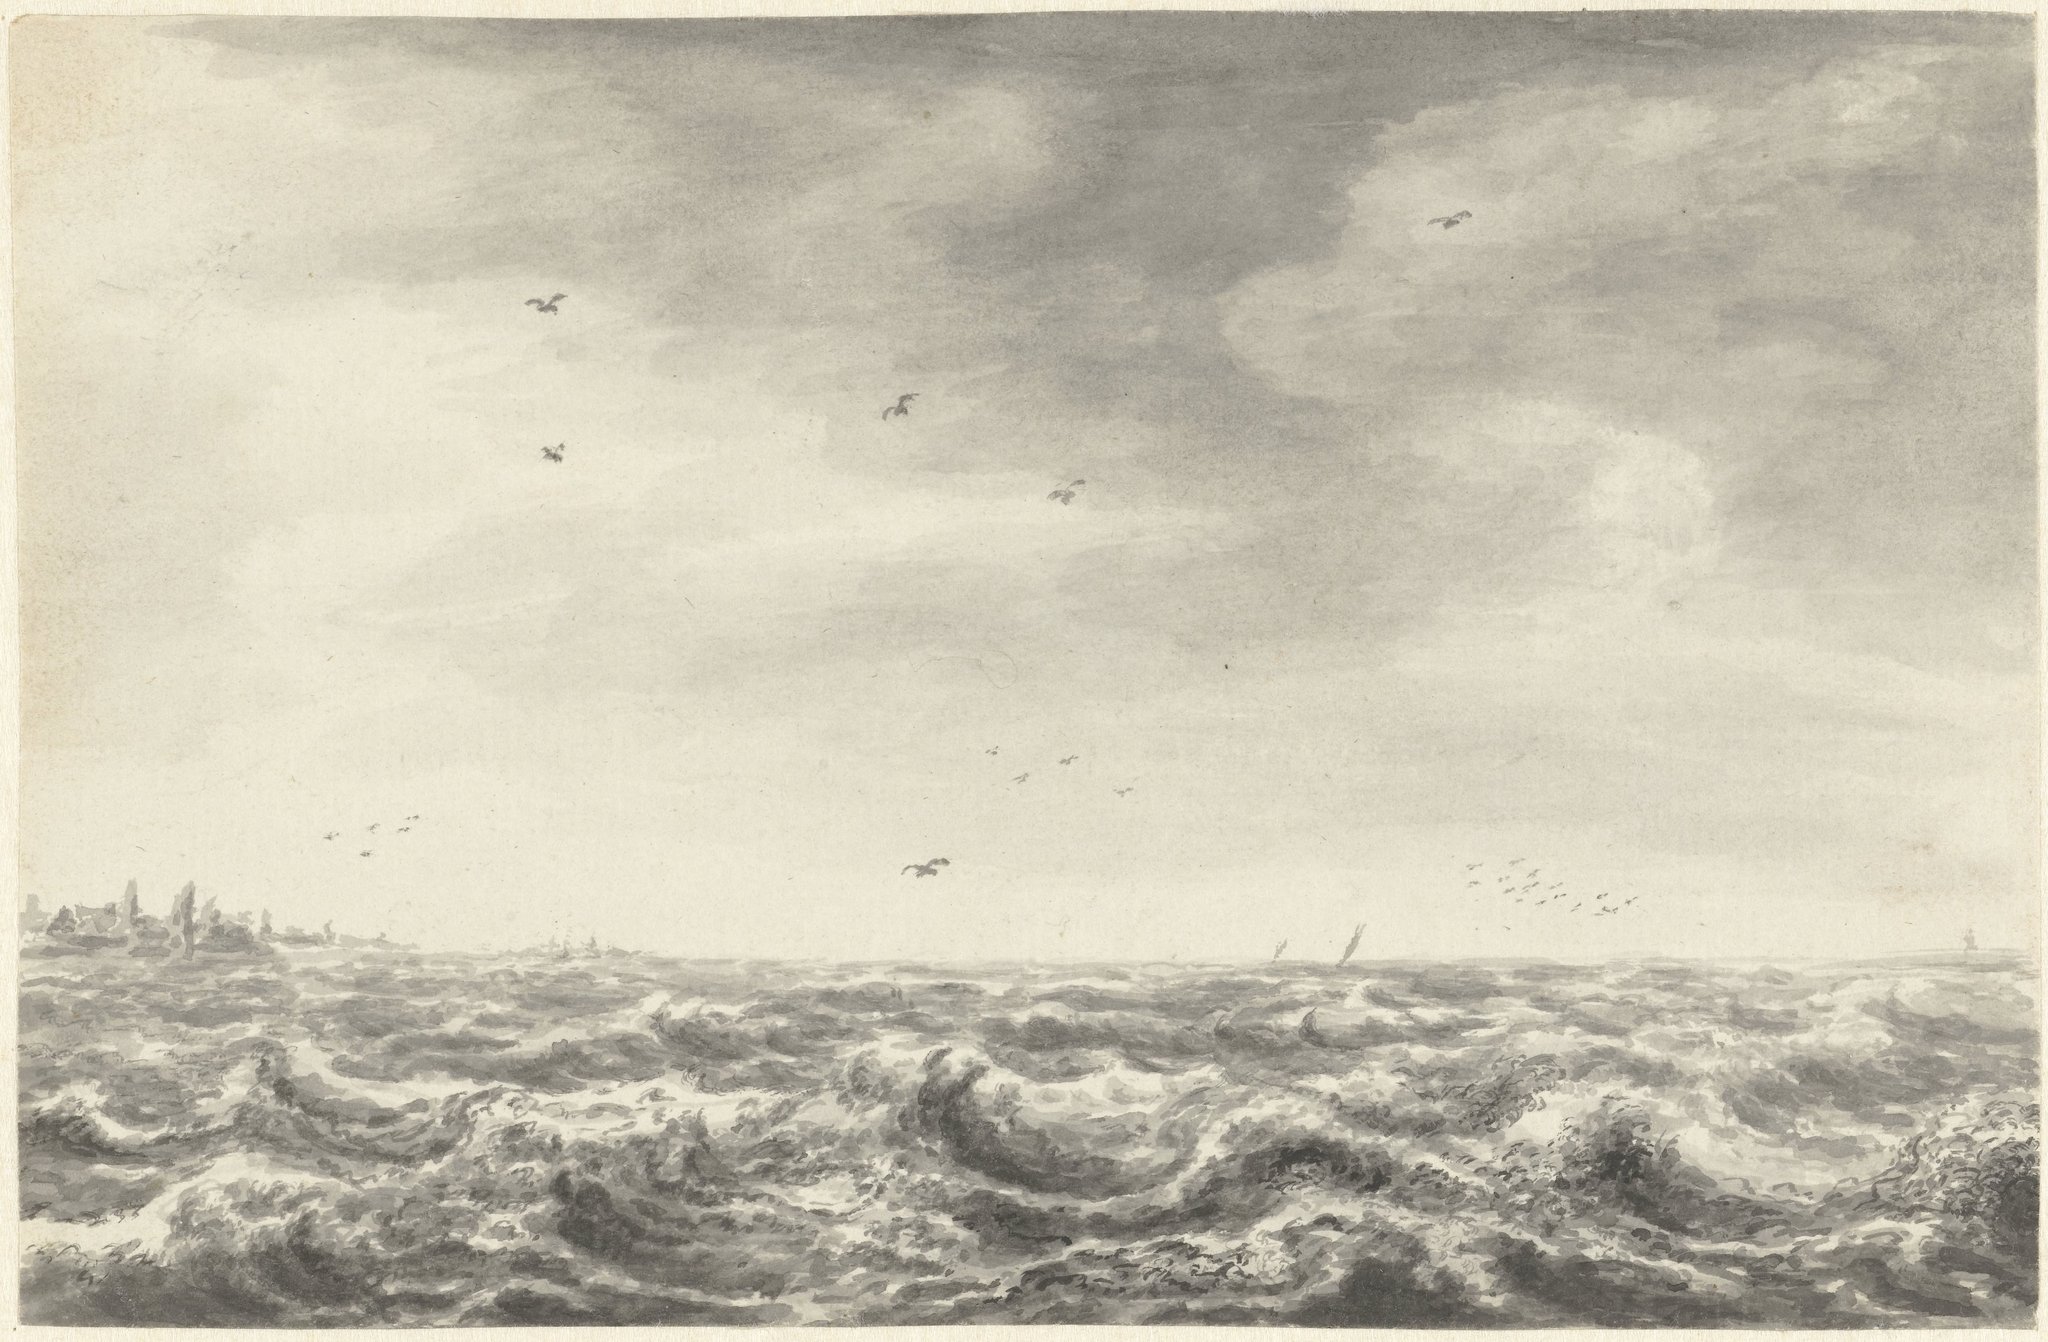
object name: drawing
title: Zeegezicht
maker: pieter idserts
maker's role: draughtsman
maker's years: 1698-1781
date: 1708-1781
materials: paper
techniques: brush